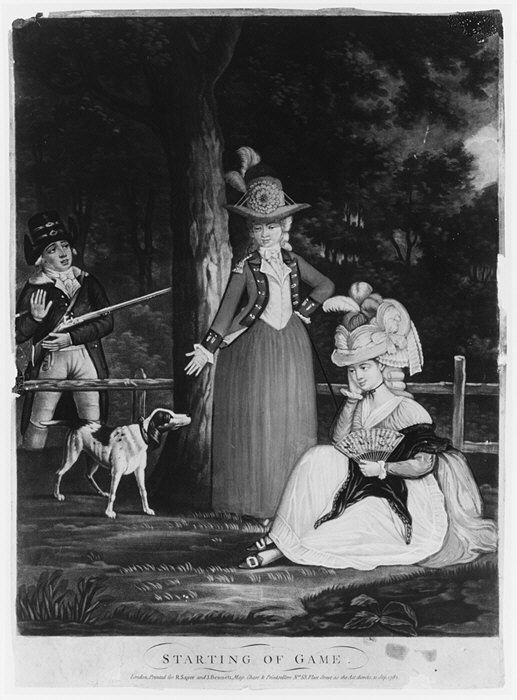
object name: print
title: Starting of Game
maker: anonymous, british, 18th century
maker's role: artist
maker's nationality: british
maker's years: 1700-1800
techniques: hand coloring, mezzotint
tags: fans,men,women,dogs,trees